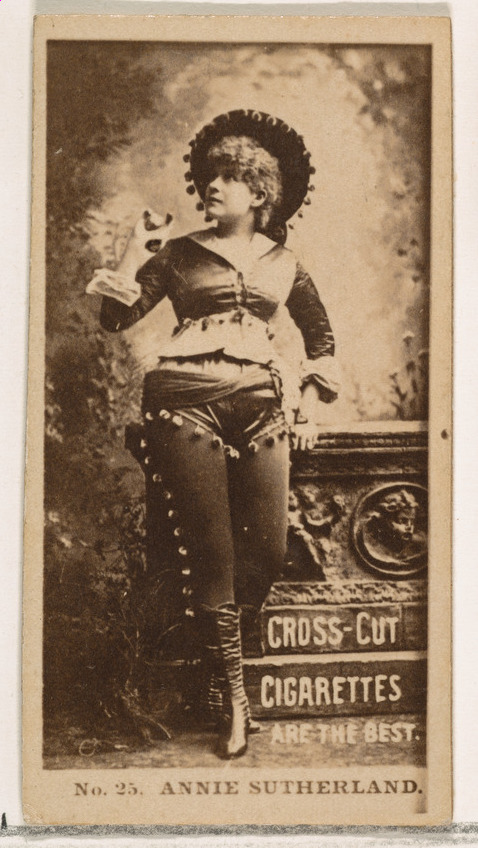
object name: print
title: Card Number 25, Annie Sutherland, from the Actors and Actresses series (N145-2) issued by Duke Sons & Co. to promote Cross Cut Cigarettes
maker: w. duke, sons & co.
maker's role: publisher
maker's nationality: american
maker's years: 1870-1920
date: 1880-1889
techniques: albumen silver print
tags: women,actresses